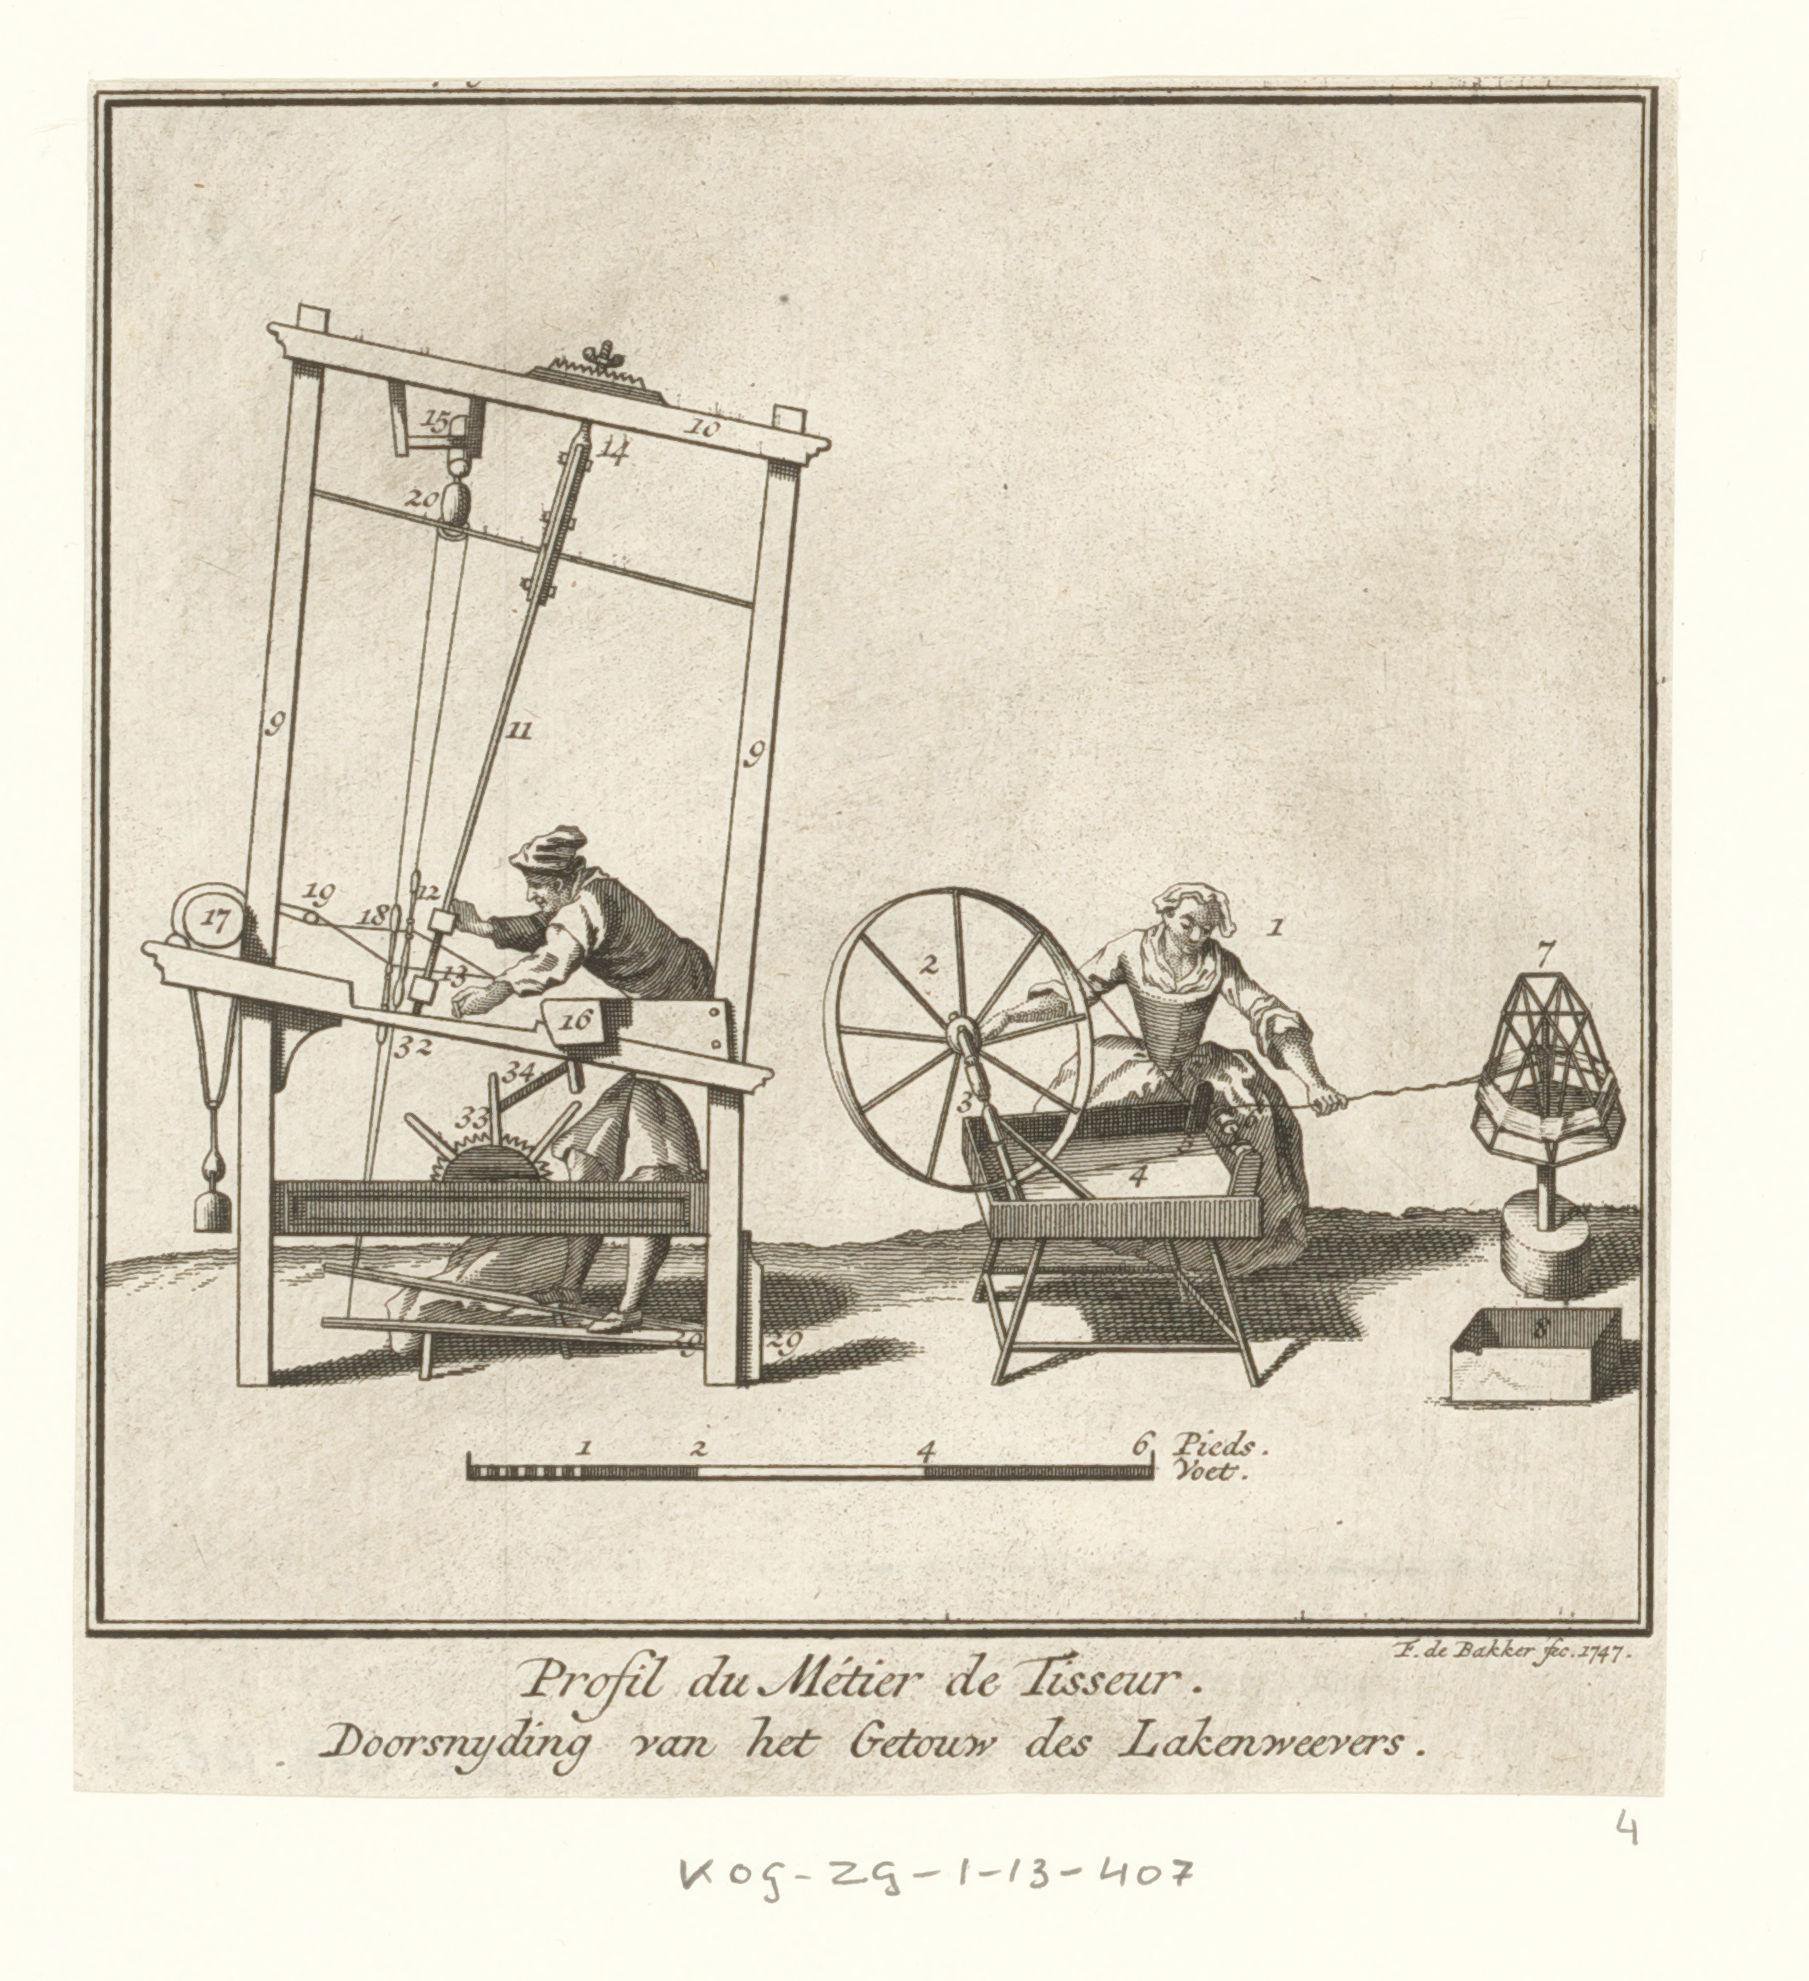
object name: print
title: Profil du Métier de Tisseur / Doorsnijding van het Getouw des Lakenweevers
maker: frans de bakker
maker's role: print maker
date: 1747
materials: paper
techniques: engraving, etching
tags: textile industry and clothing industry, textile fabric, cloth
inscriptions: collector's mark: Lugt 1641, stamp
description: Prent mogelijk uit: Noël-Antoine Pluche. Schouwtoneel der natuur, of Samenspraaken over de Bysonderheden der natuurlyke histori (...). [Vertaald uit het Frans door] Pieter le Clercq. 14 dln. Amsterdam: Salomon Schouten, 1737-1749, dl. 12, na p. 288.